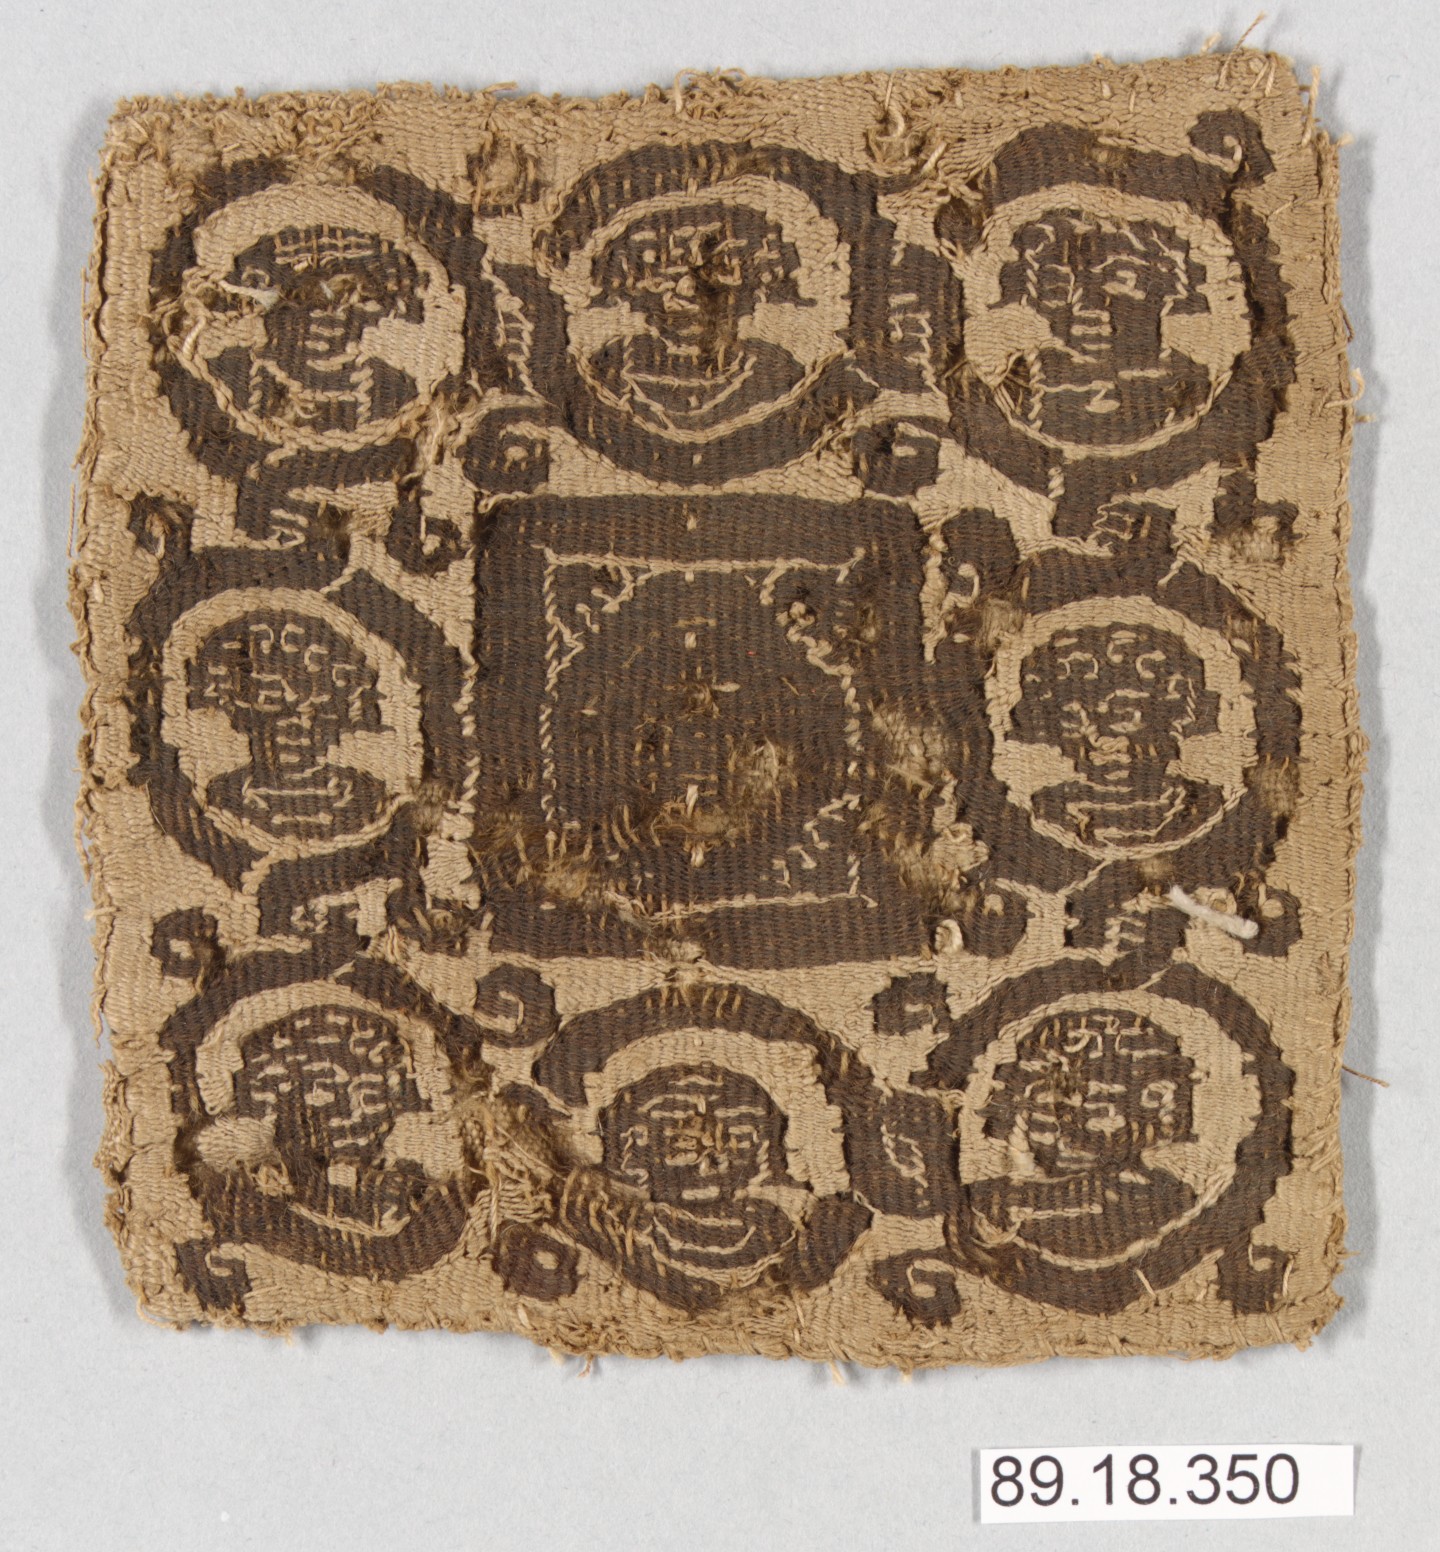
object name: textile fragment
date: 201-400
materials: linen, wool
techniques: weave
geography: egypt